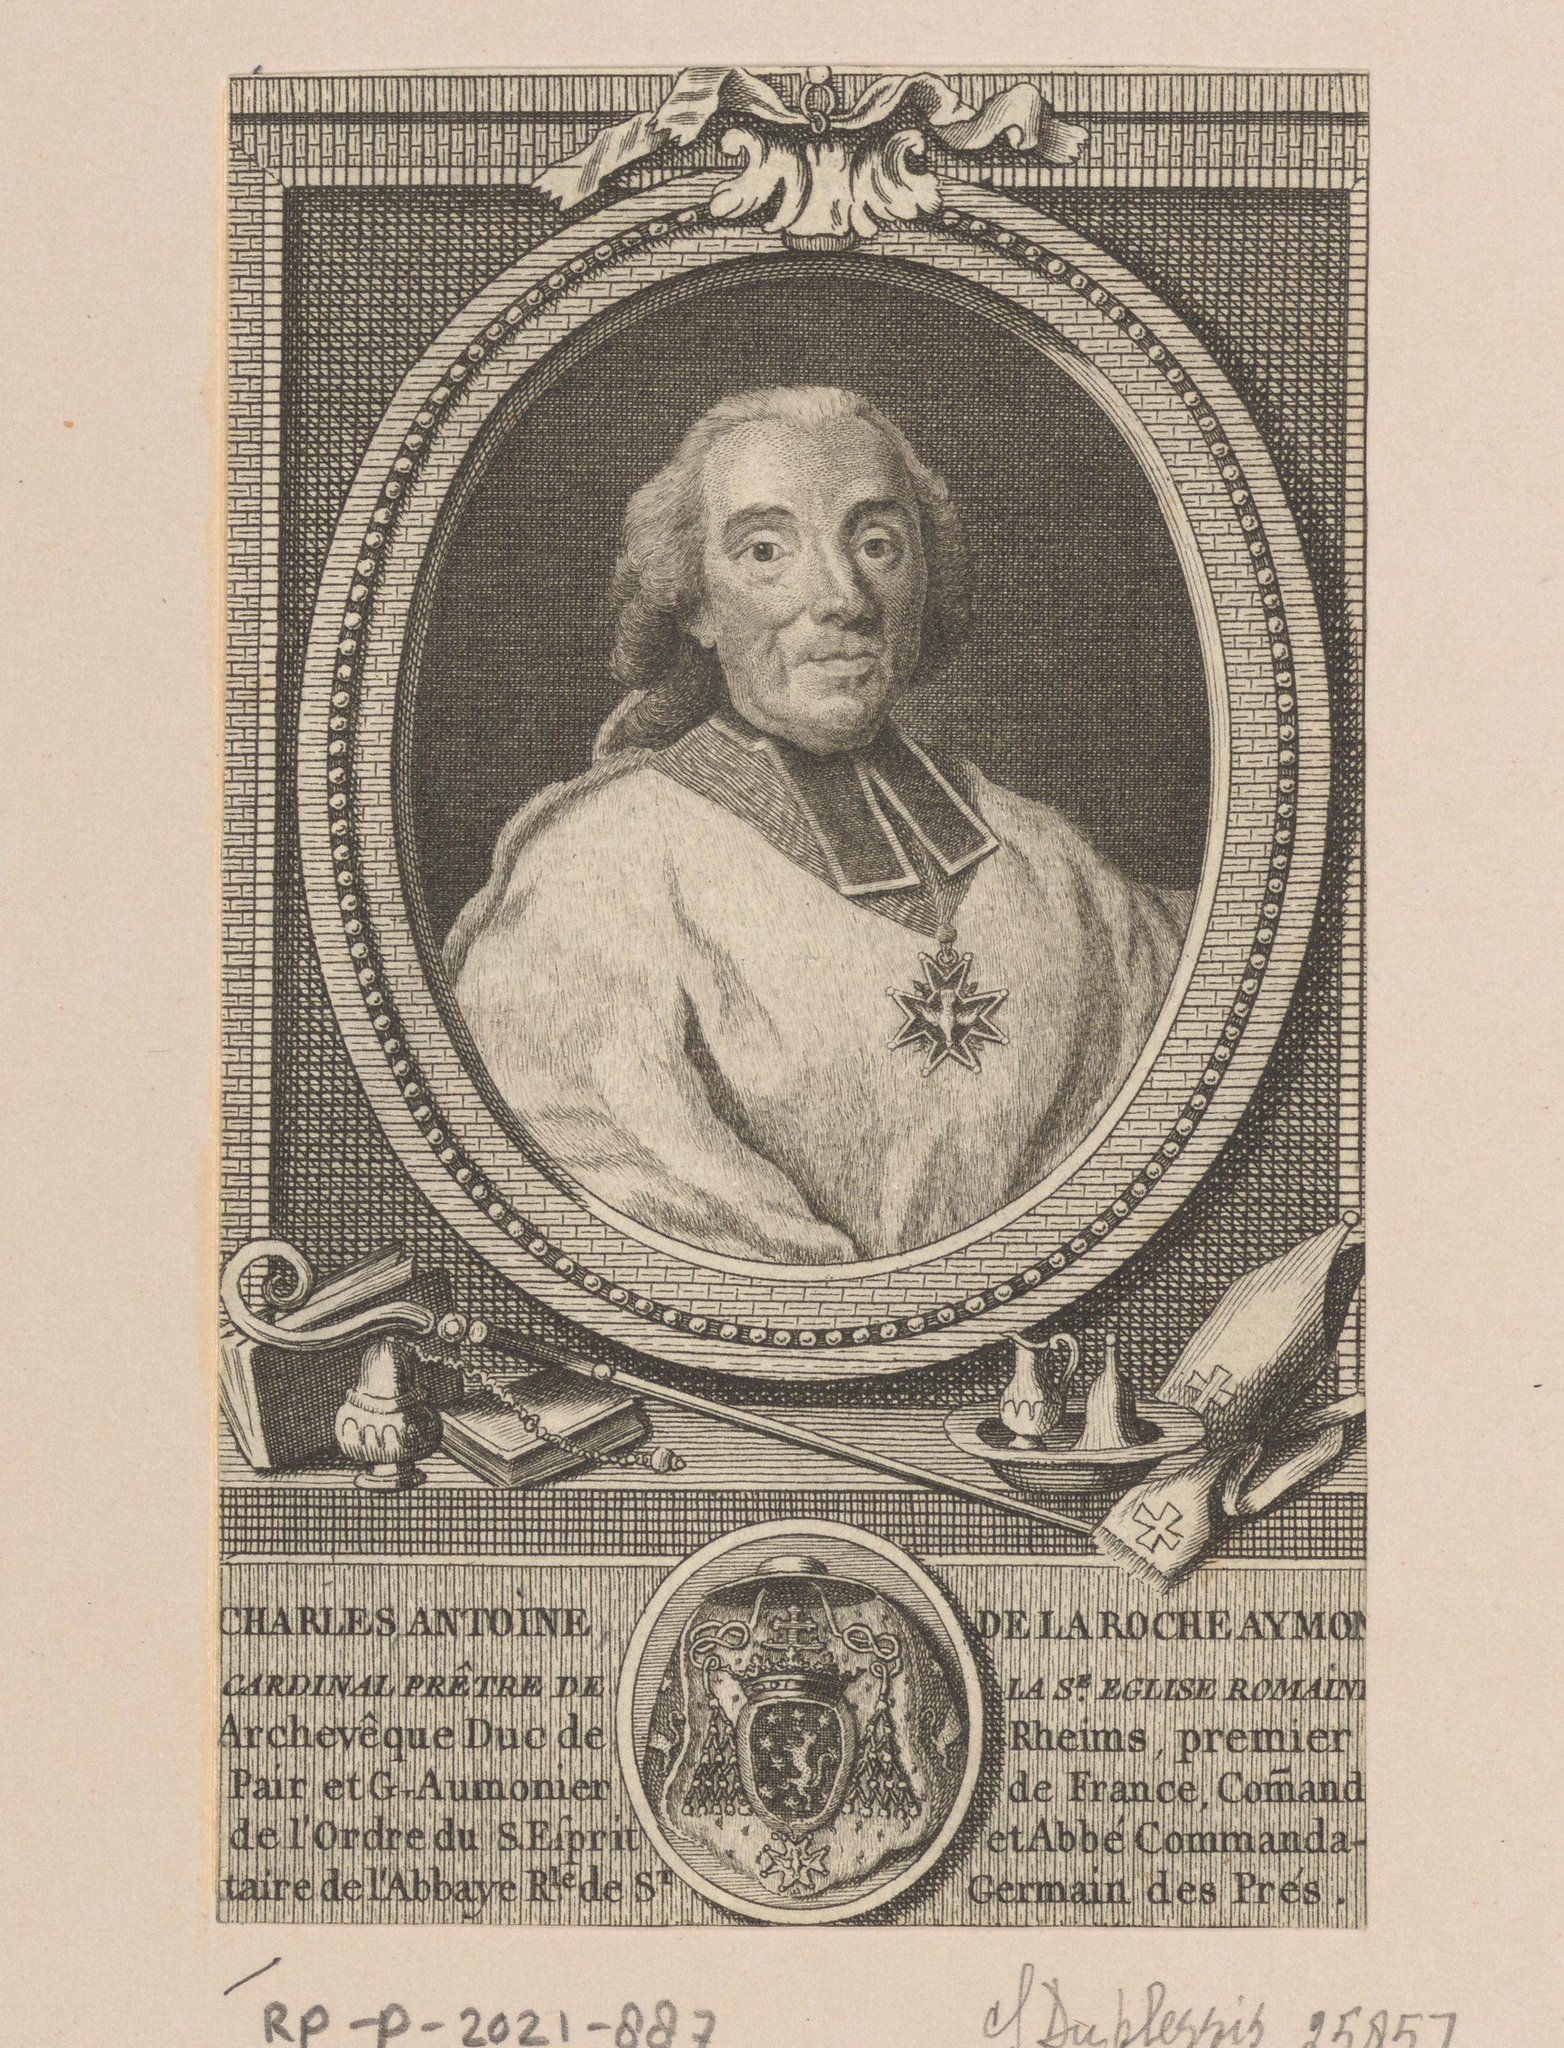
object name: print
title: Portret van Charles Antoine de La Roche-Aymon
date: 1771-1799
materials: paper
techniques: etching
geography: france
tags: paris, insignia of bishop, e.g. mitre, crozier, historical persons, armorial bearing, heraldry